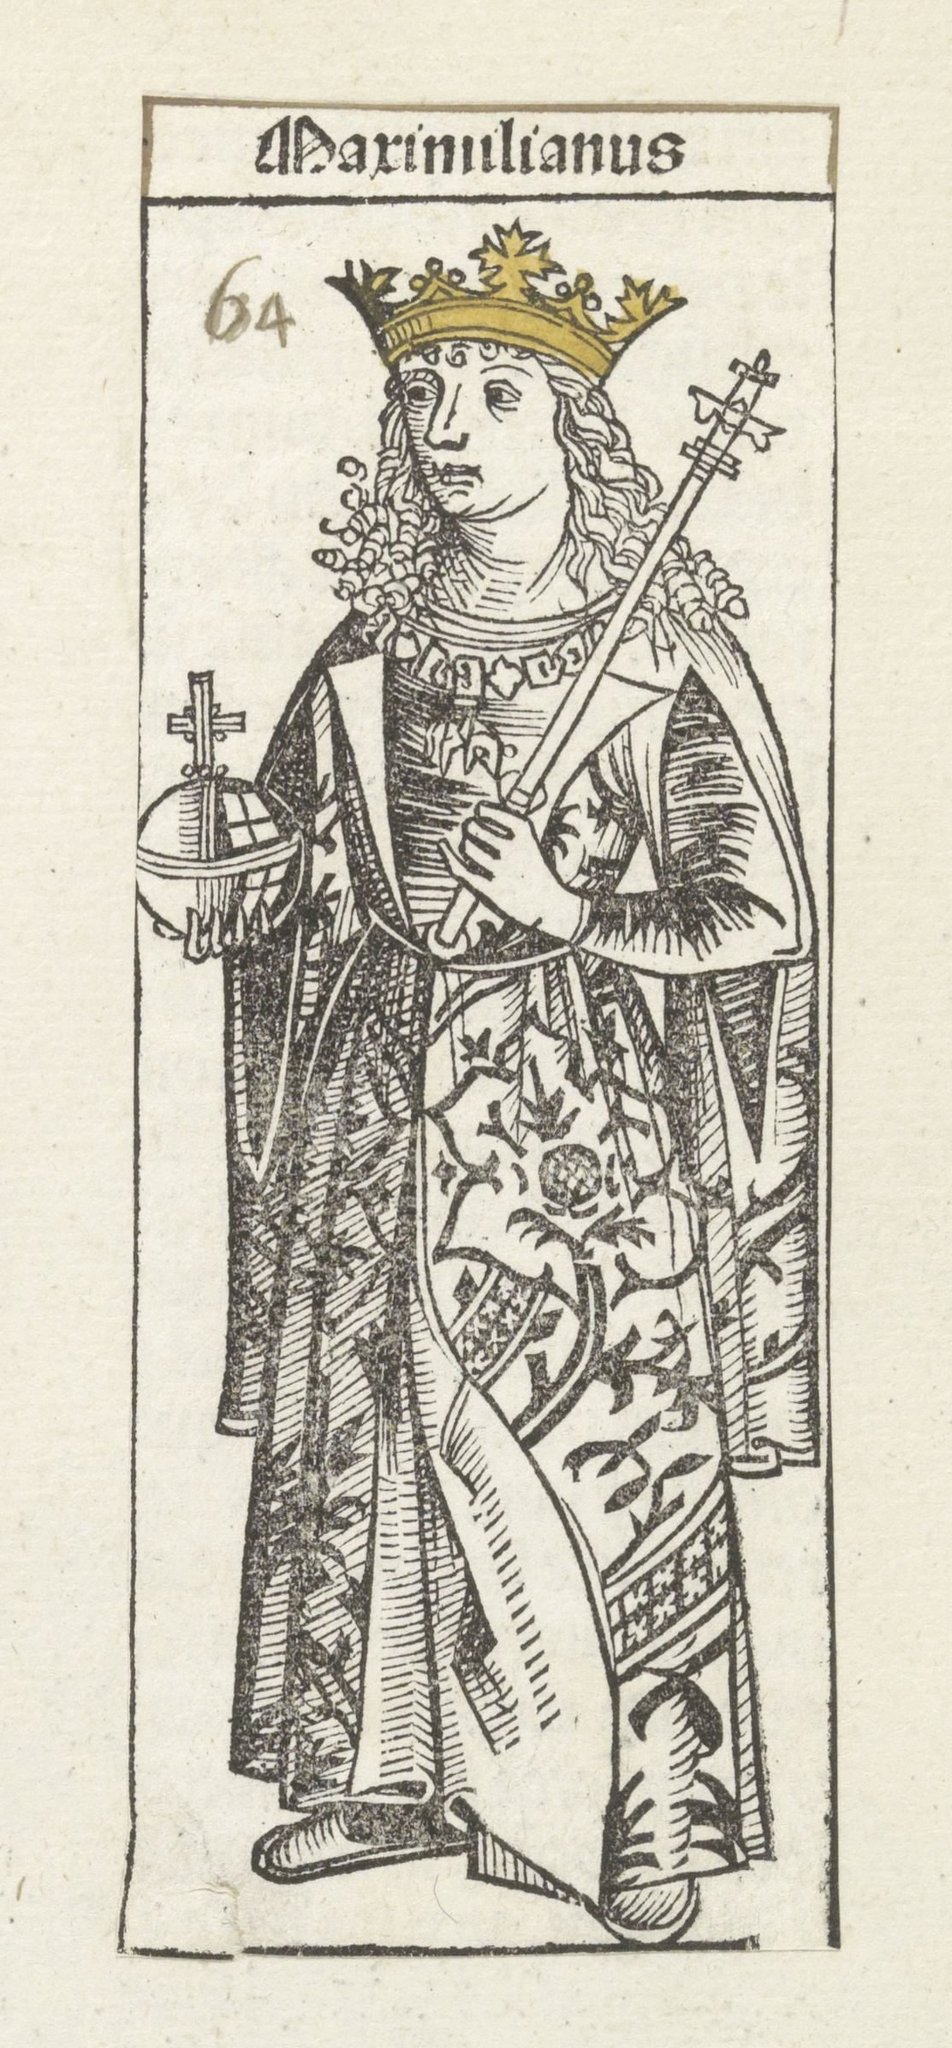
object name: album leaf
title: Keizer Maximiliaan I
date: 1493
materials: paper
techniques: colour, letterpress printing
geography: nuremberg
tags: maximilian i (holy roman emperor), emperor, king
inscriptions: inscription: ‘64’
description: Een koning met rijksappel en scepter, ten voeten uit. De voorstelling is onderdeel van de opeenvolging keizers in de Liber Chronicarum. De tekst identificeert de man als Maximiliaan I. De prent maakt deel uit van een album.